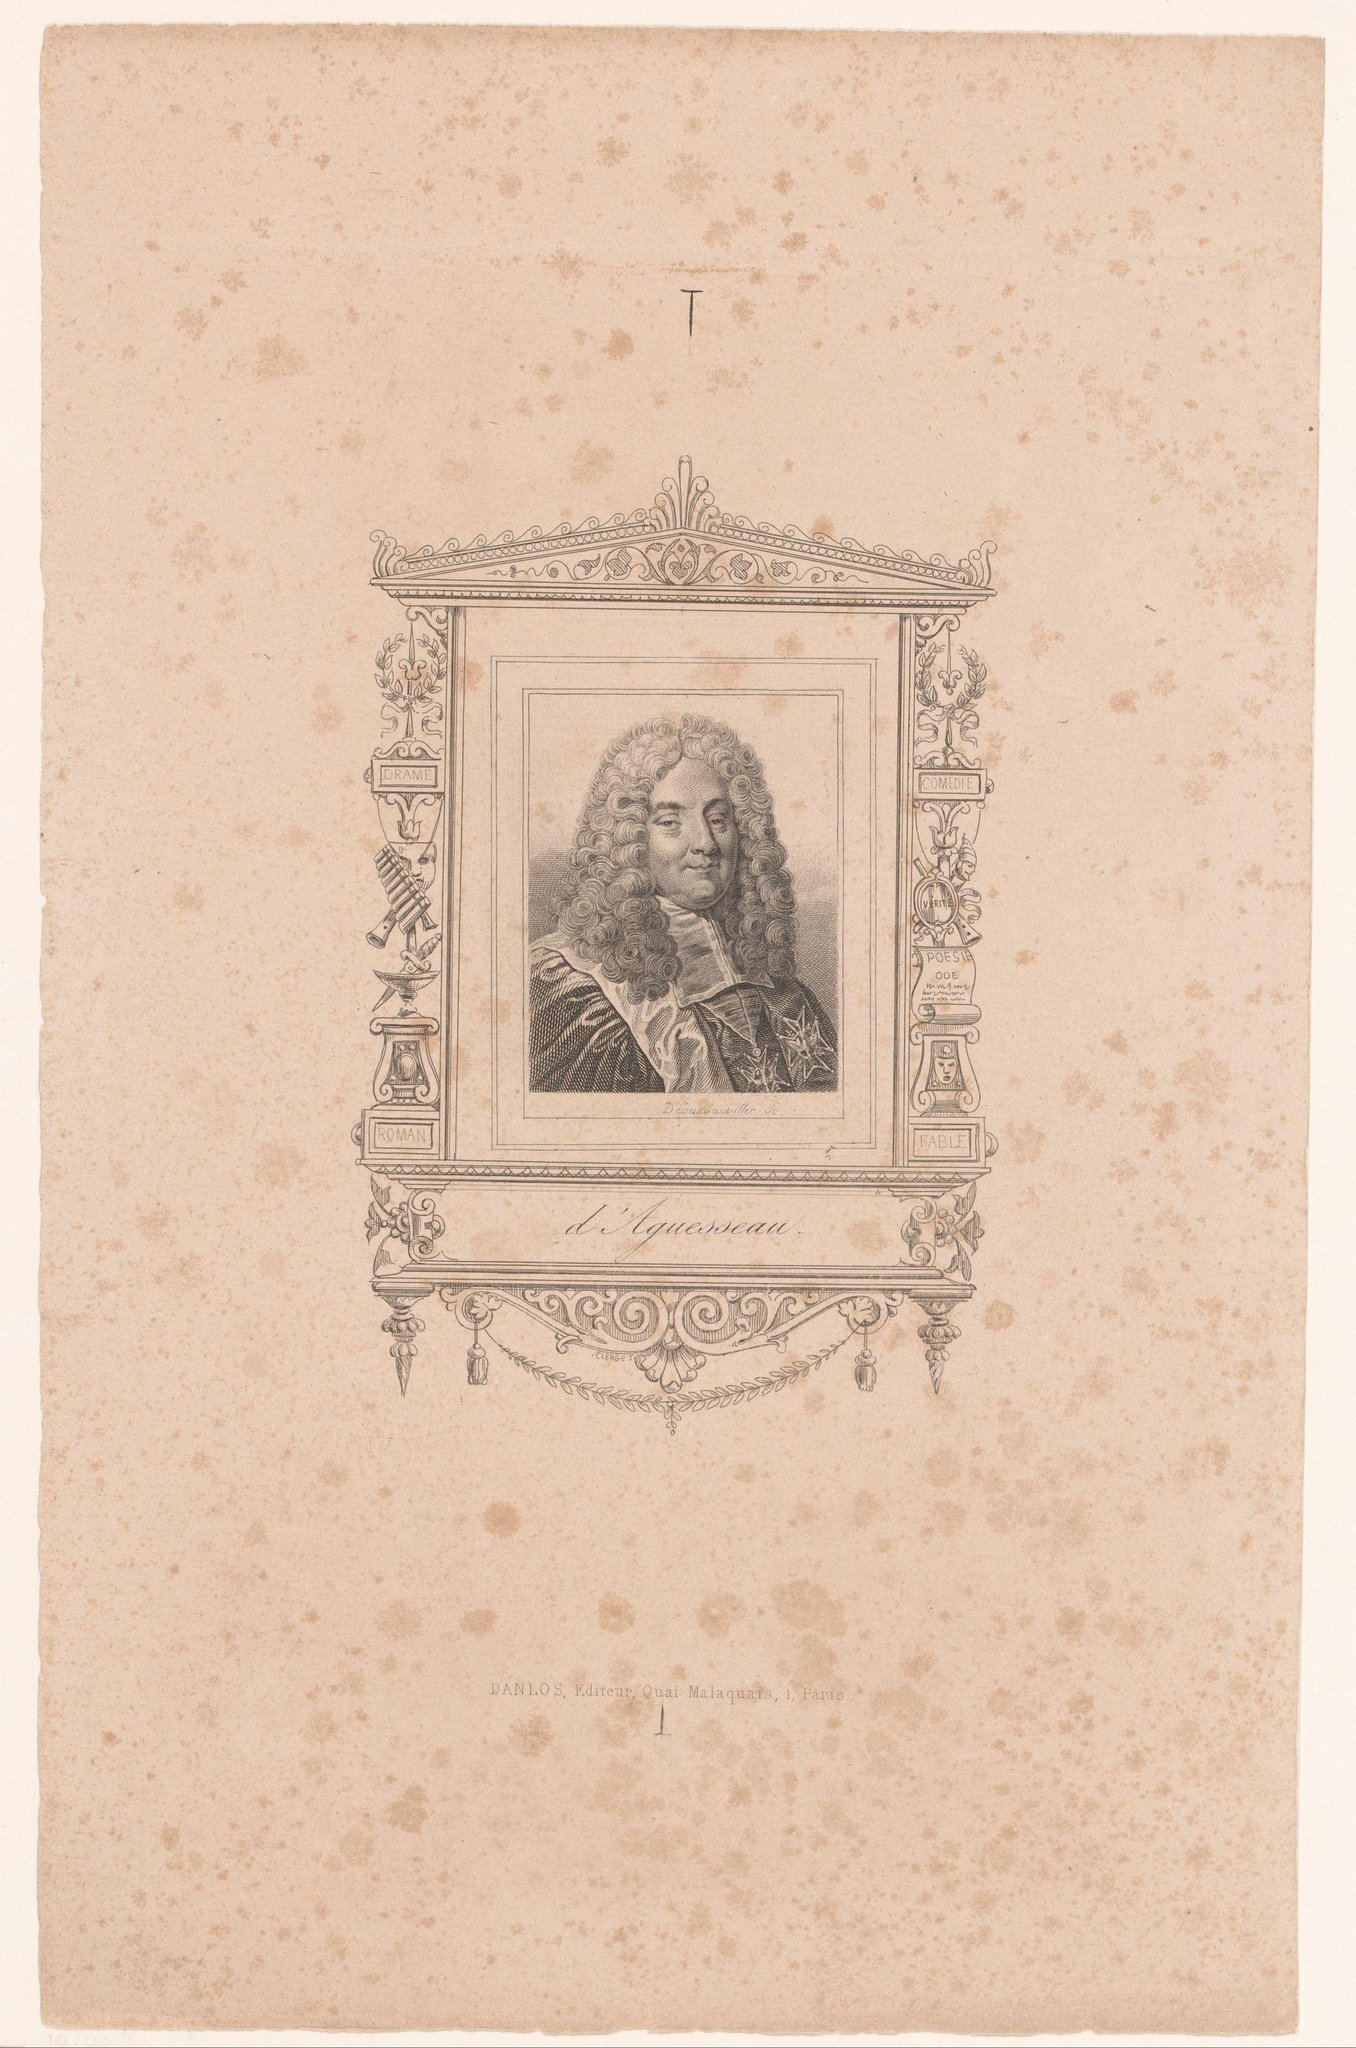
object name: print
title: Portret van Henri François d'Aguesseau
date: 1793-1897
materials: paper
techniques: engraving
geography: paris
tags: governmental and representative bodies, historical persons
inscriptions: collector's mark: Lugt 2228